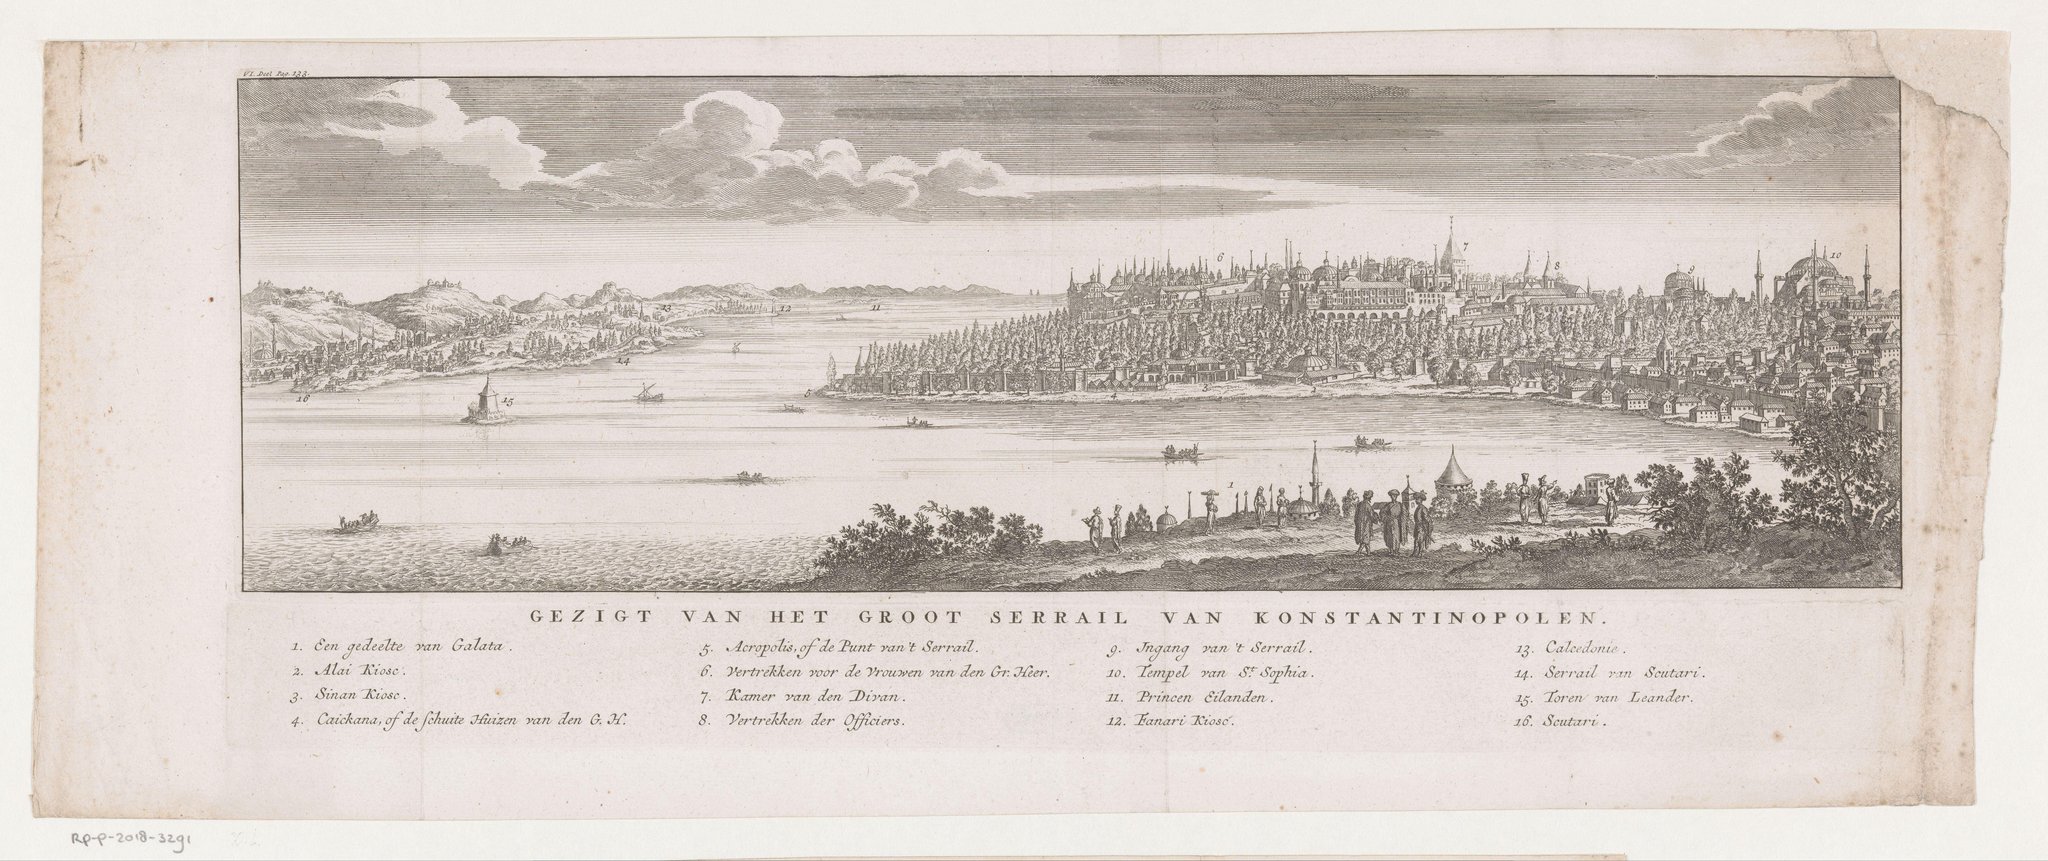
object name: print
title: Gezigt van het groot serrail van Konstantinopolen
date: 1683-1739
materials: paper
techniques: etching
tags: prospect of city, town panorama, silhouette of city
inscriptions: collector's mark: Lugt 2228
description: Gezicht op Constantinopel (Istanbul) met het paleis van de sultan. Onder de afbeelding staat een legenda met nummers. linksboven: "VI Deel. Pag. 133." Gezicht vanuit het noordwesten, staande in het stadsdeel Galata, op de akropolis met het Topkapi paleis. Uiterst rechts de tot moskee omgebouwde Hagia Sophia.